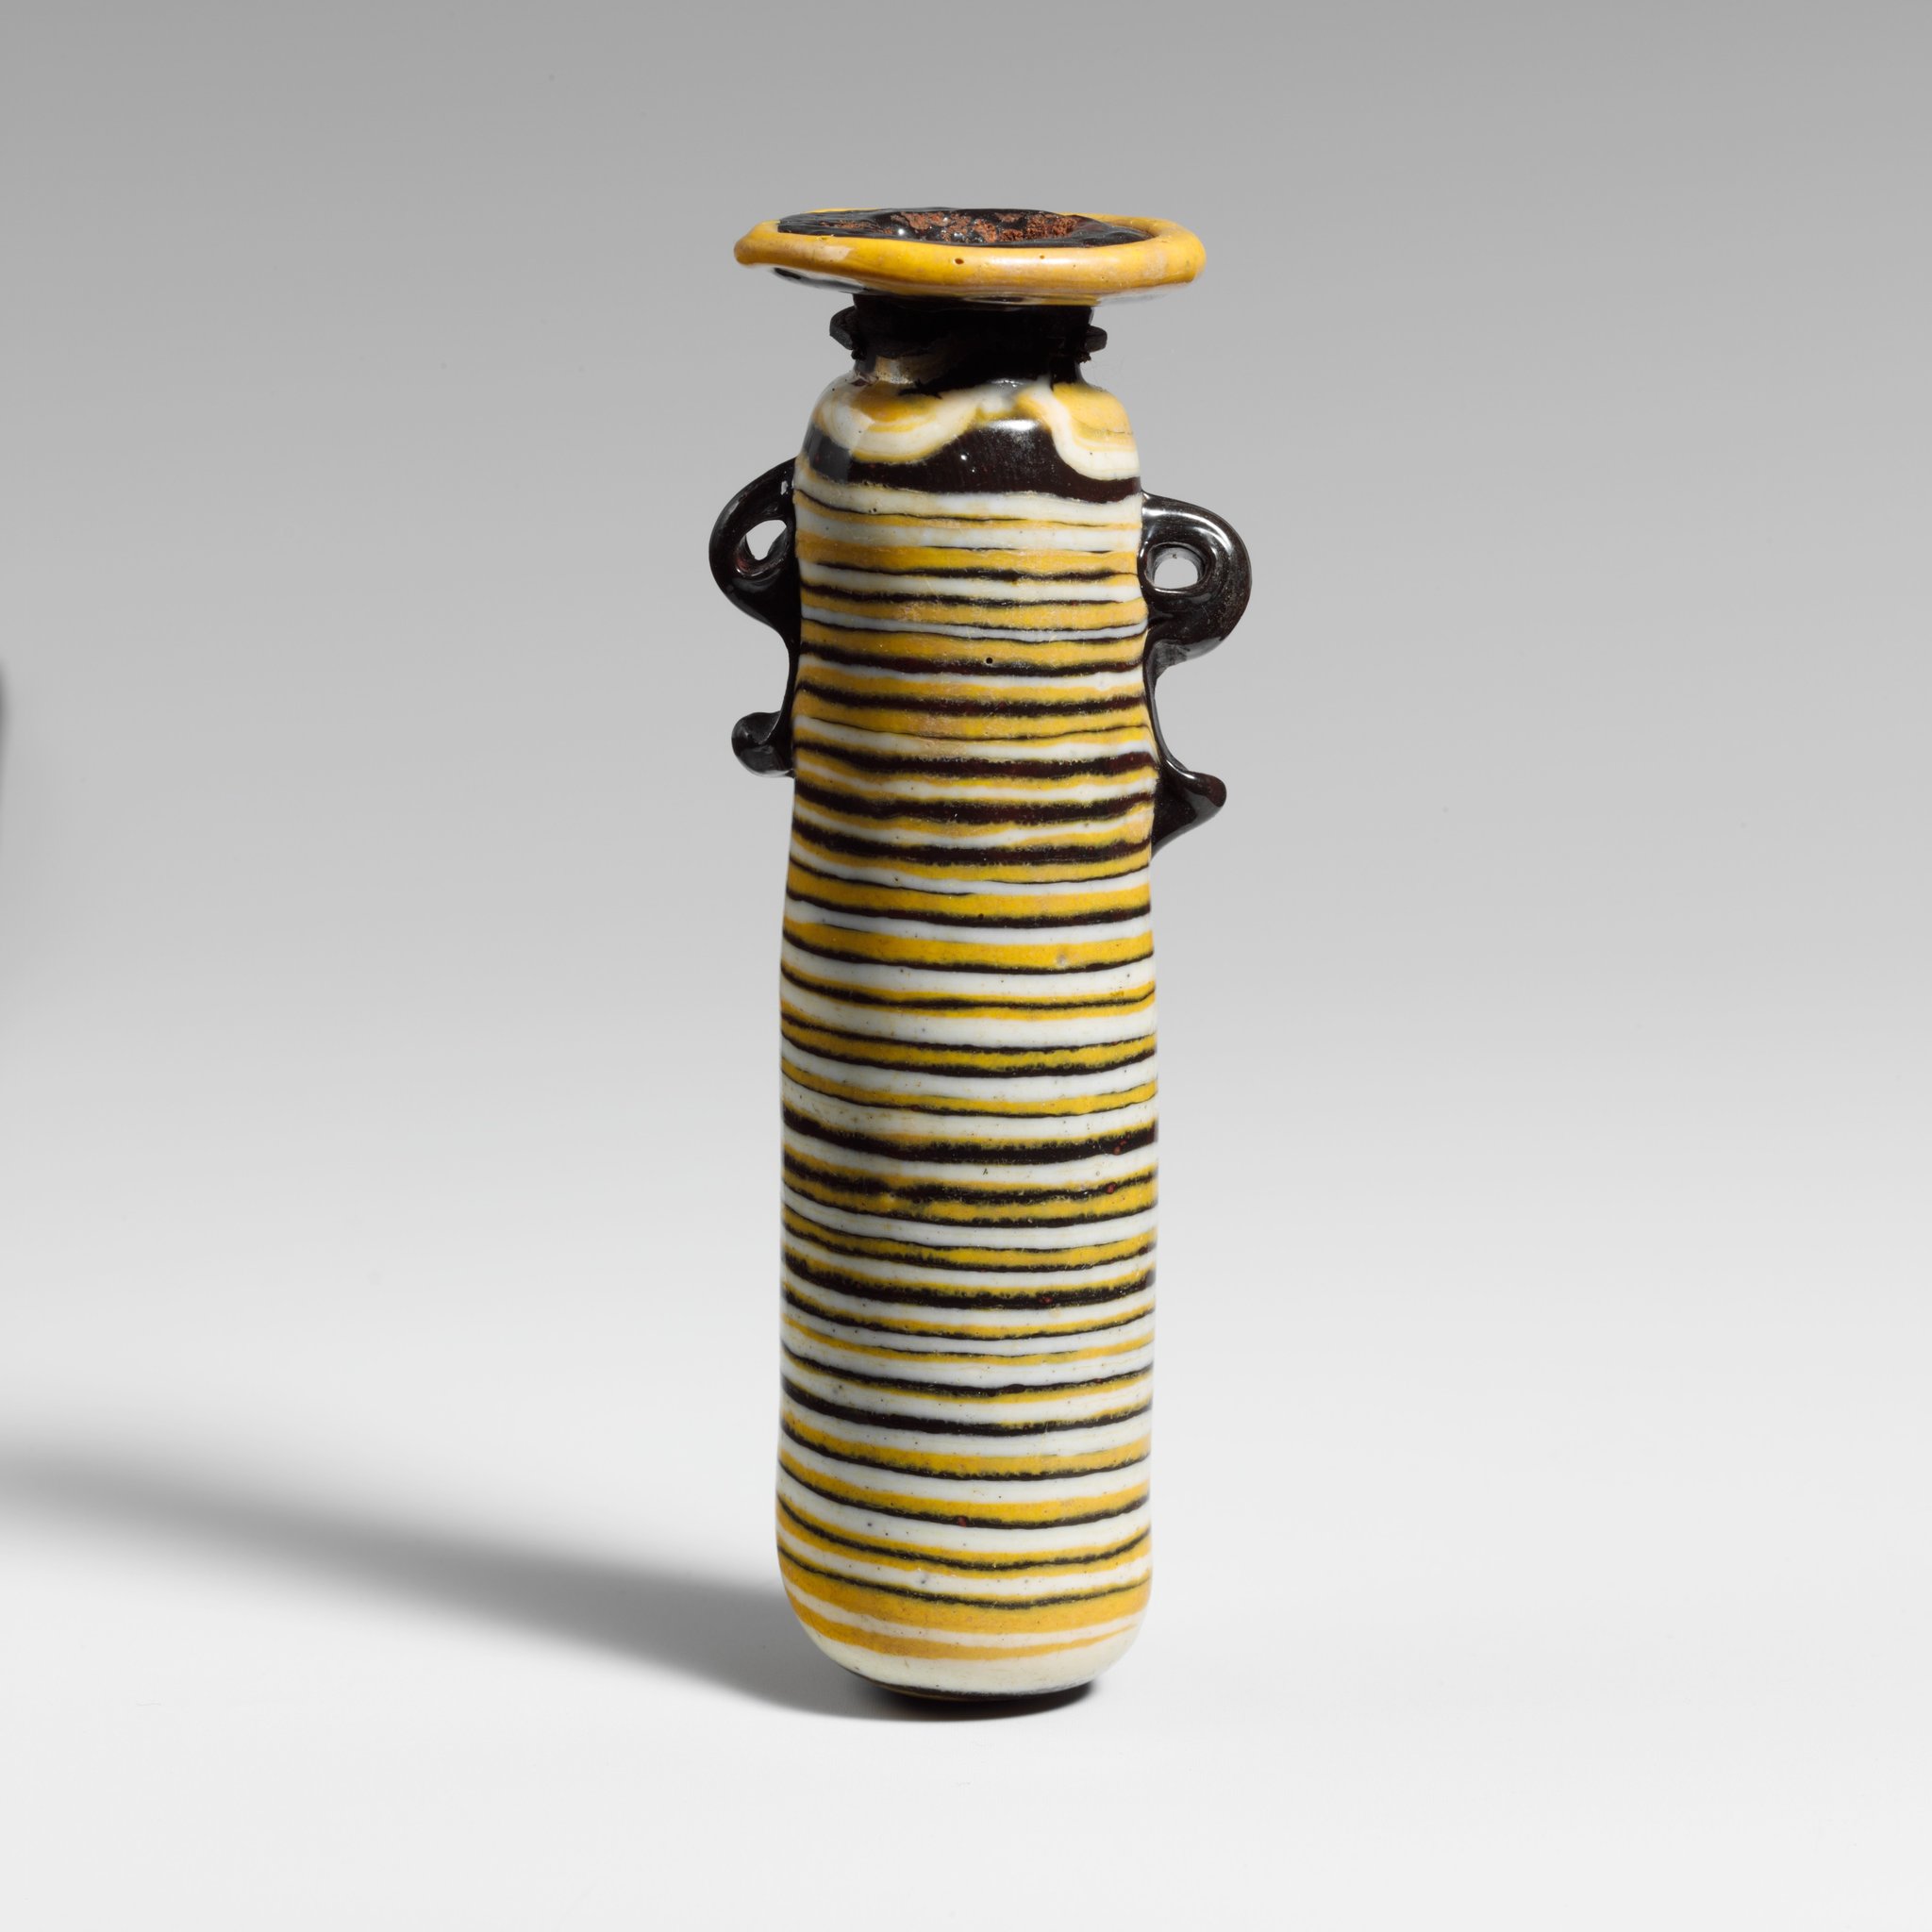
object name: alabastron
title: Glass alabastron (perfume bottle)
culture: greek, eastern mediterranean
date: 534-401 BCE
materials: glass